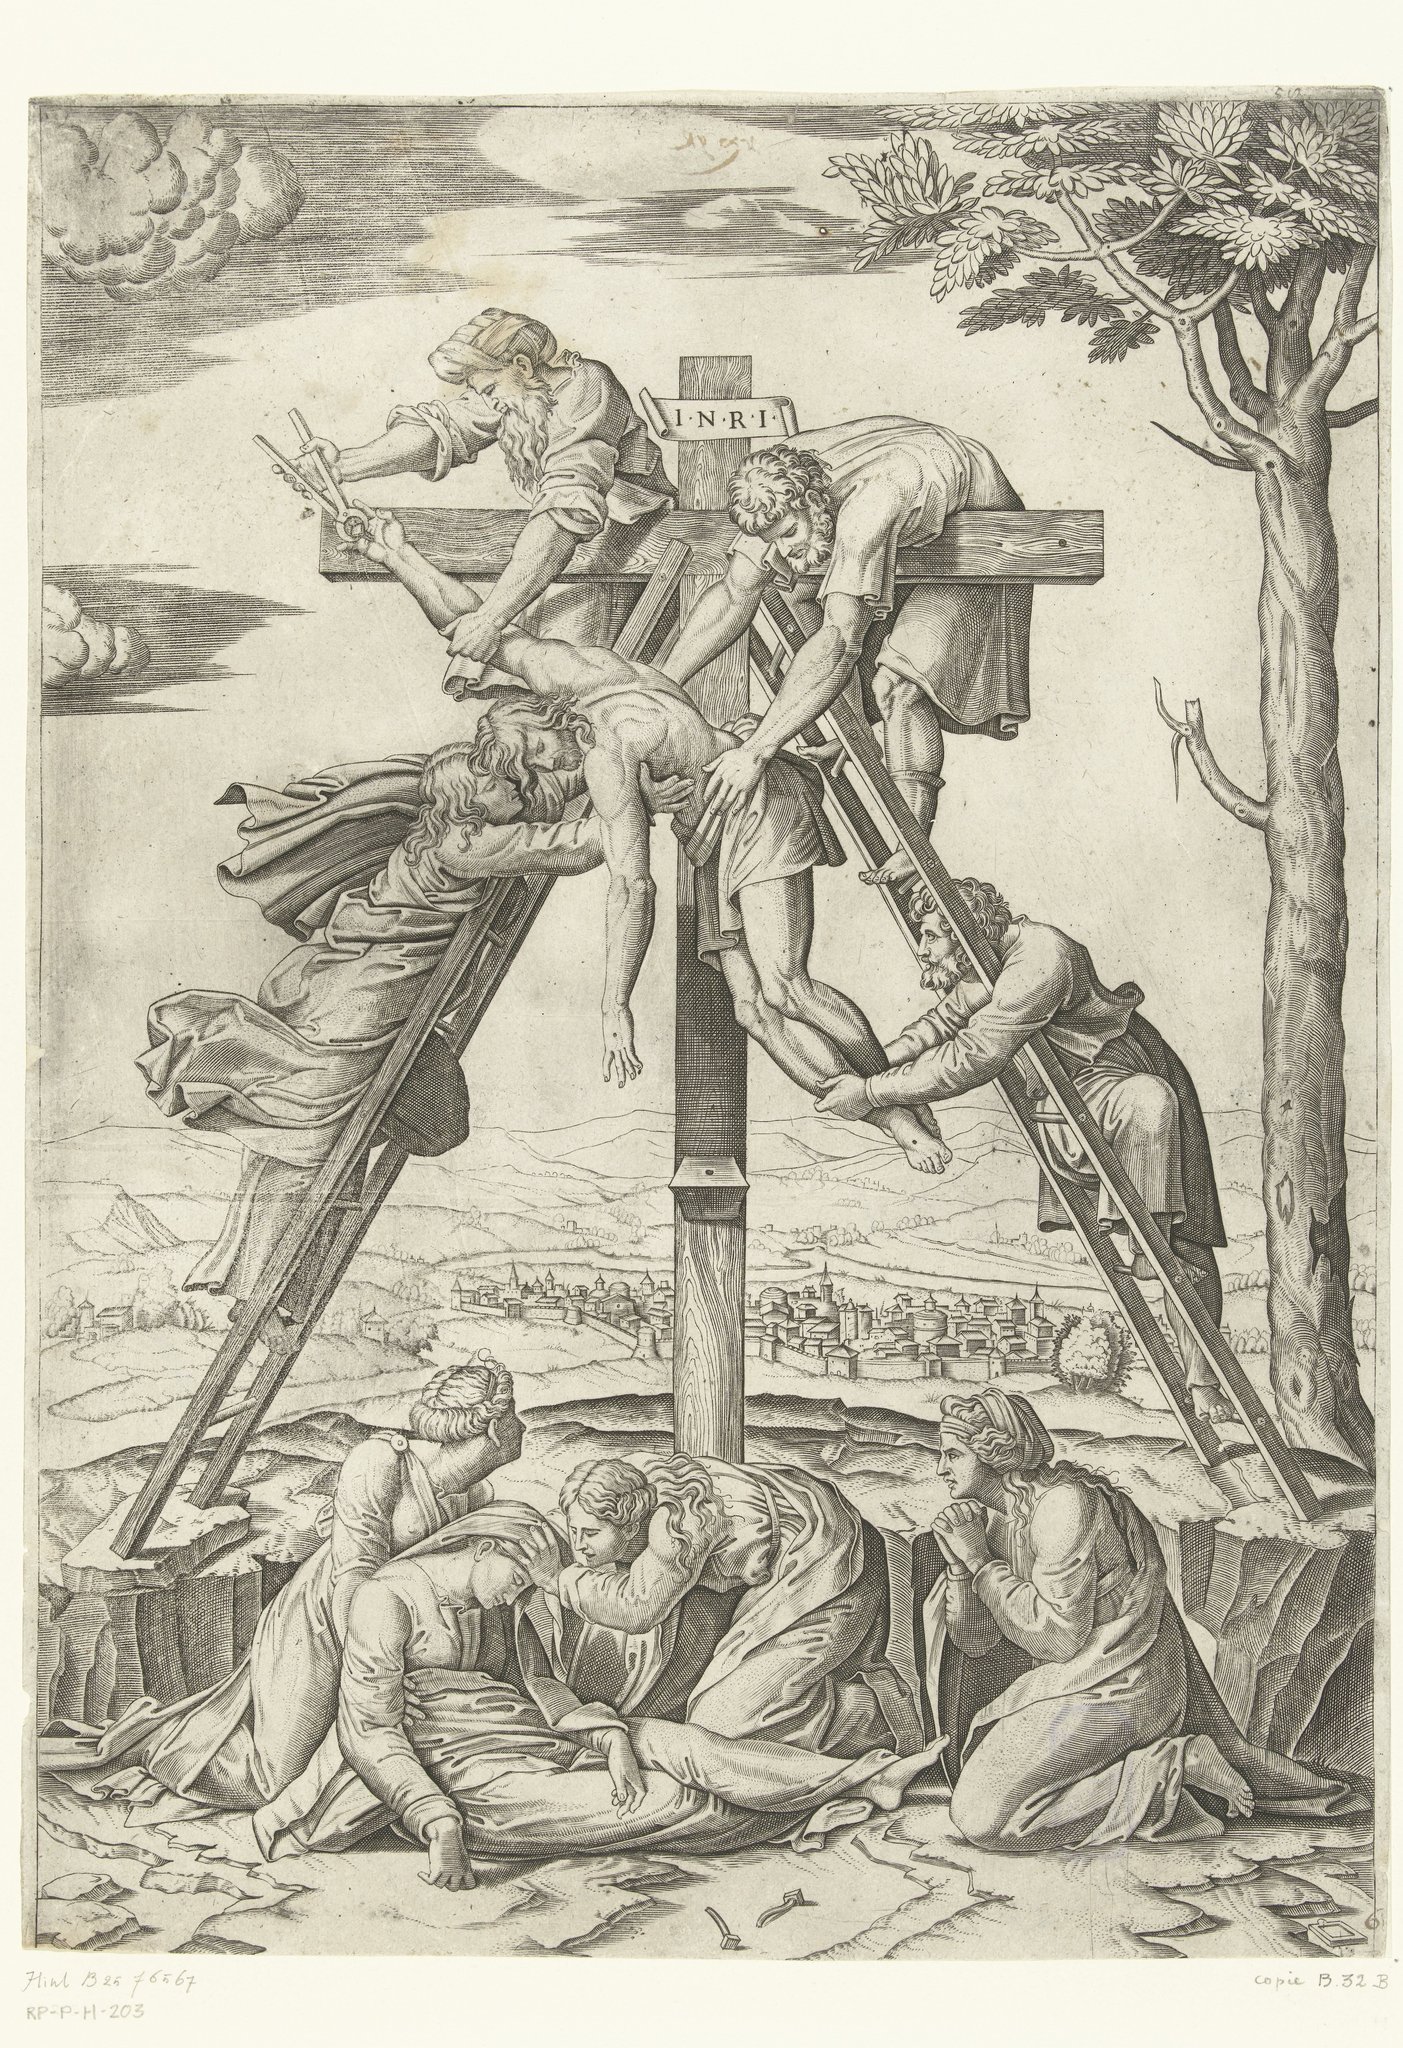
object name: print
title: Kruisafneming van Christus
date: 1520-1571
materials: paper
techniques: engraving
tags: descent from the cross: christ is taken down from the cross, usually by nicodemus and joseph of arimathaea who are standing on the ladders (both arms of christ detached)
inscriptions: inscription: ‘B 25 f 65-67’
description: Kopie naar prent van Marcantonio Raimondi. Raimondi baseerde zich op een ontwerp van Raphael.